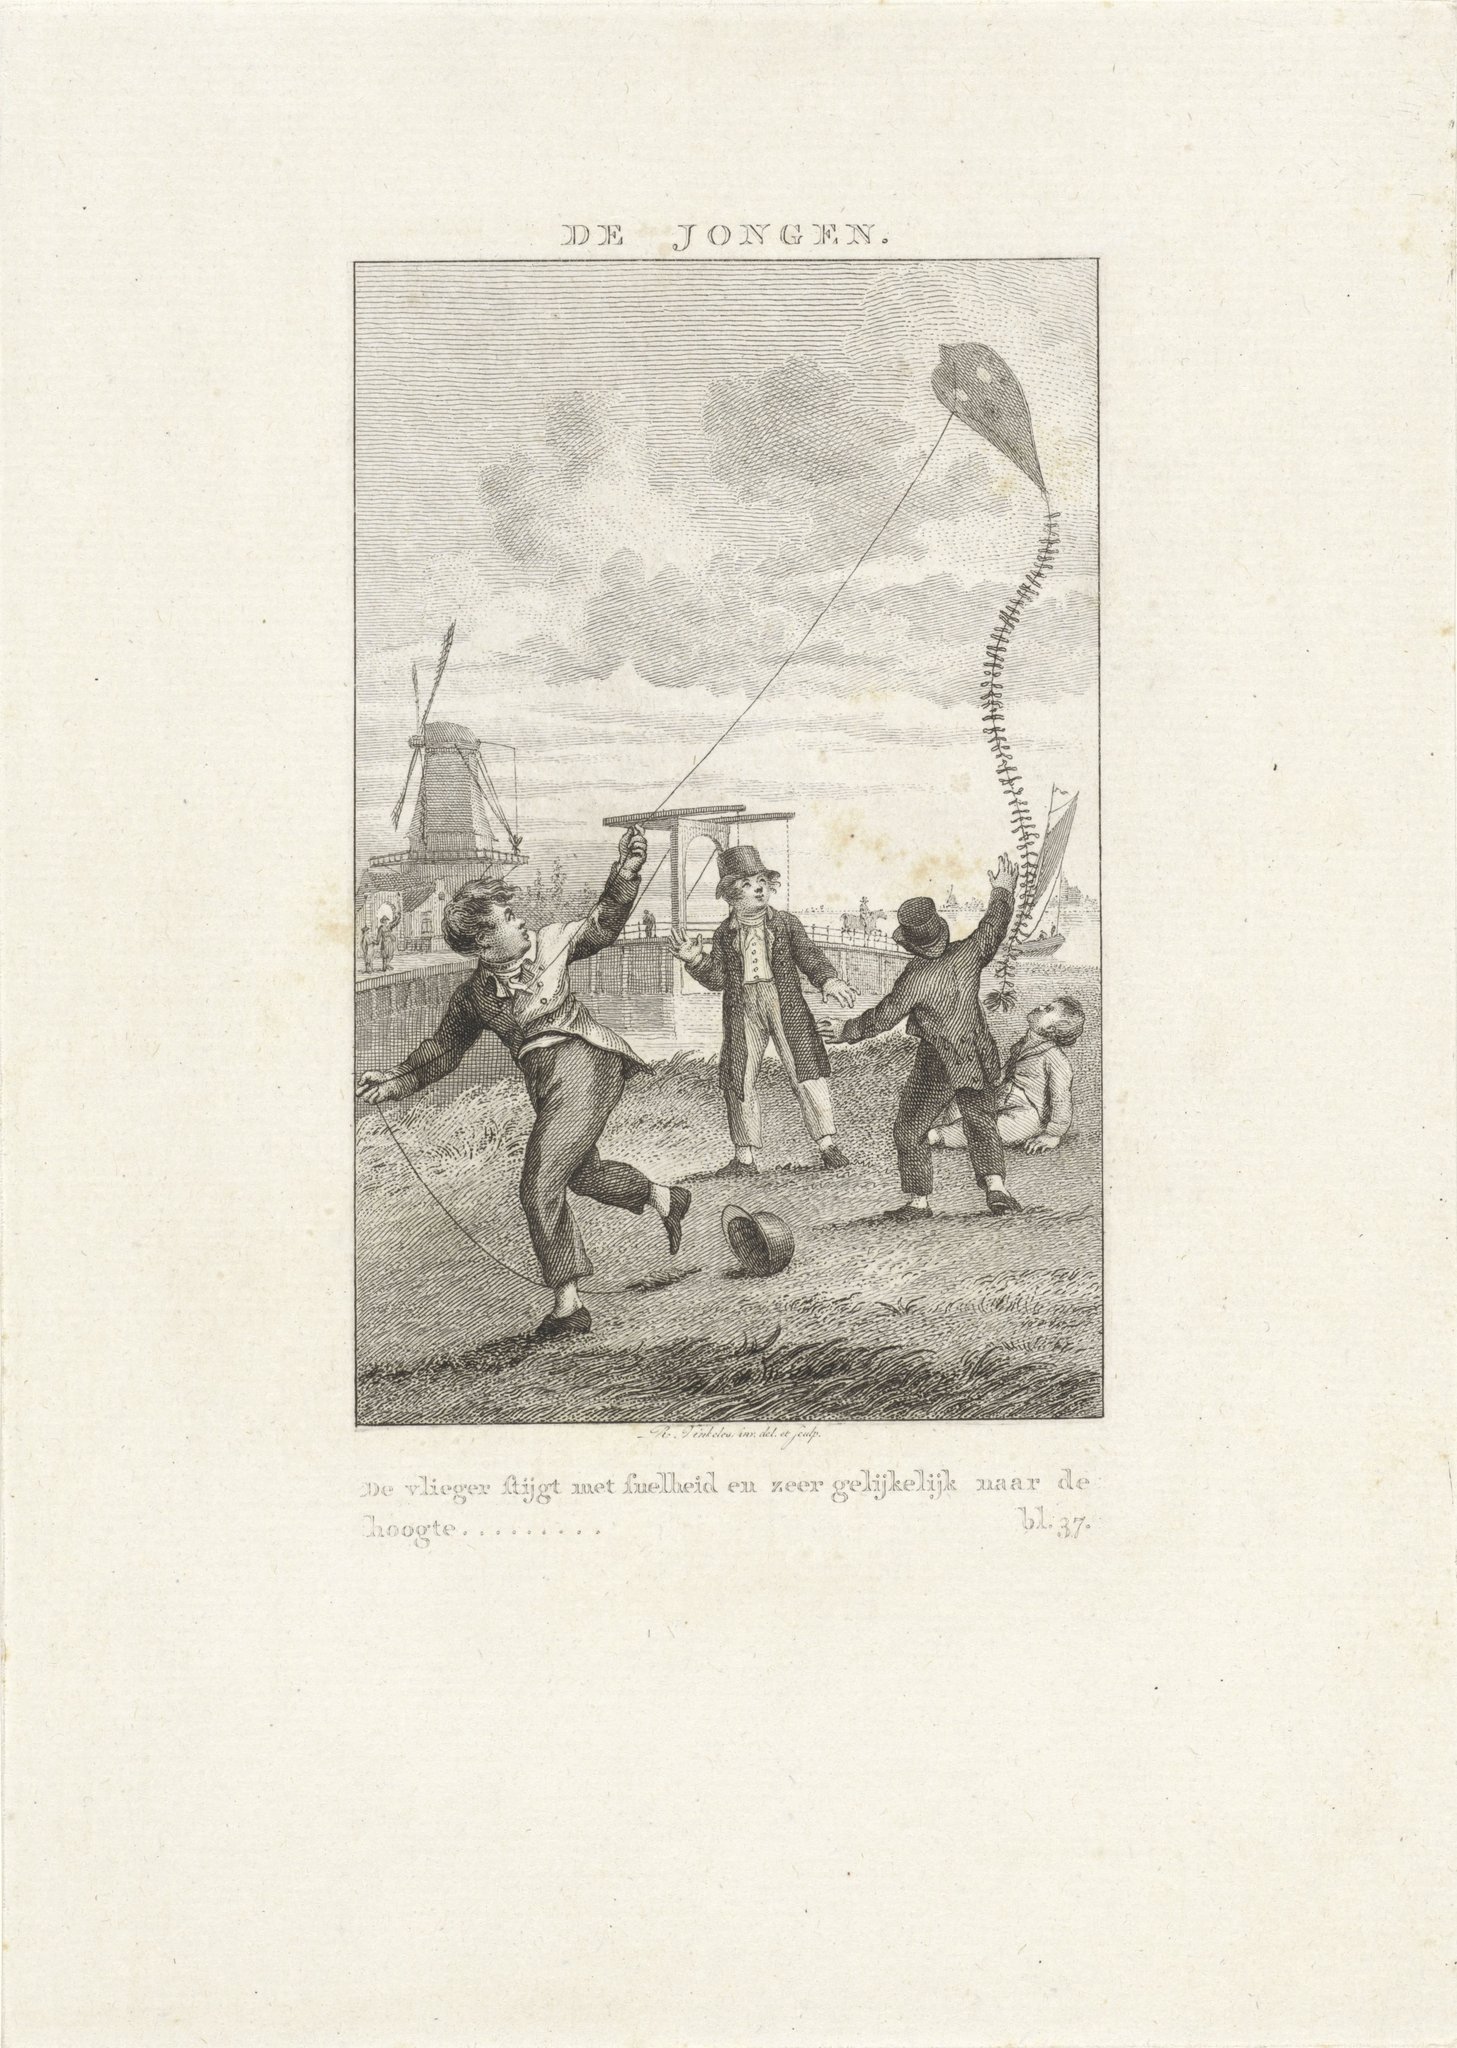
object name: print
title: De Jongen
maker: reinier vinkeles (i)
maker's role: draughtsman, print maker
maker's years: 1741-1816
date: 1809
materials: paper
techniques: engraving, etching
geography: amsterdam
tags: the ages of man, youth, adolescent, windmill in landscape, (flying a) kite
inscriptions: collector's mark: Lugt 2228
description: Enkele jongens kijken hoe een jongen een vlieger in de lucht laat zweven. Op de achtergrond een molen en een rivier met boten. De prent is een illustratie voor een boek over de vier 'tijdperken' van de man, van het tijdperk 'de jongen'.